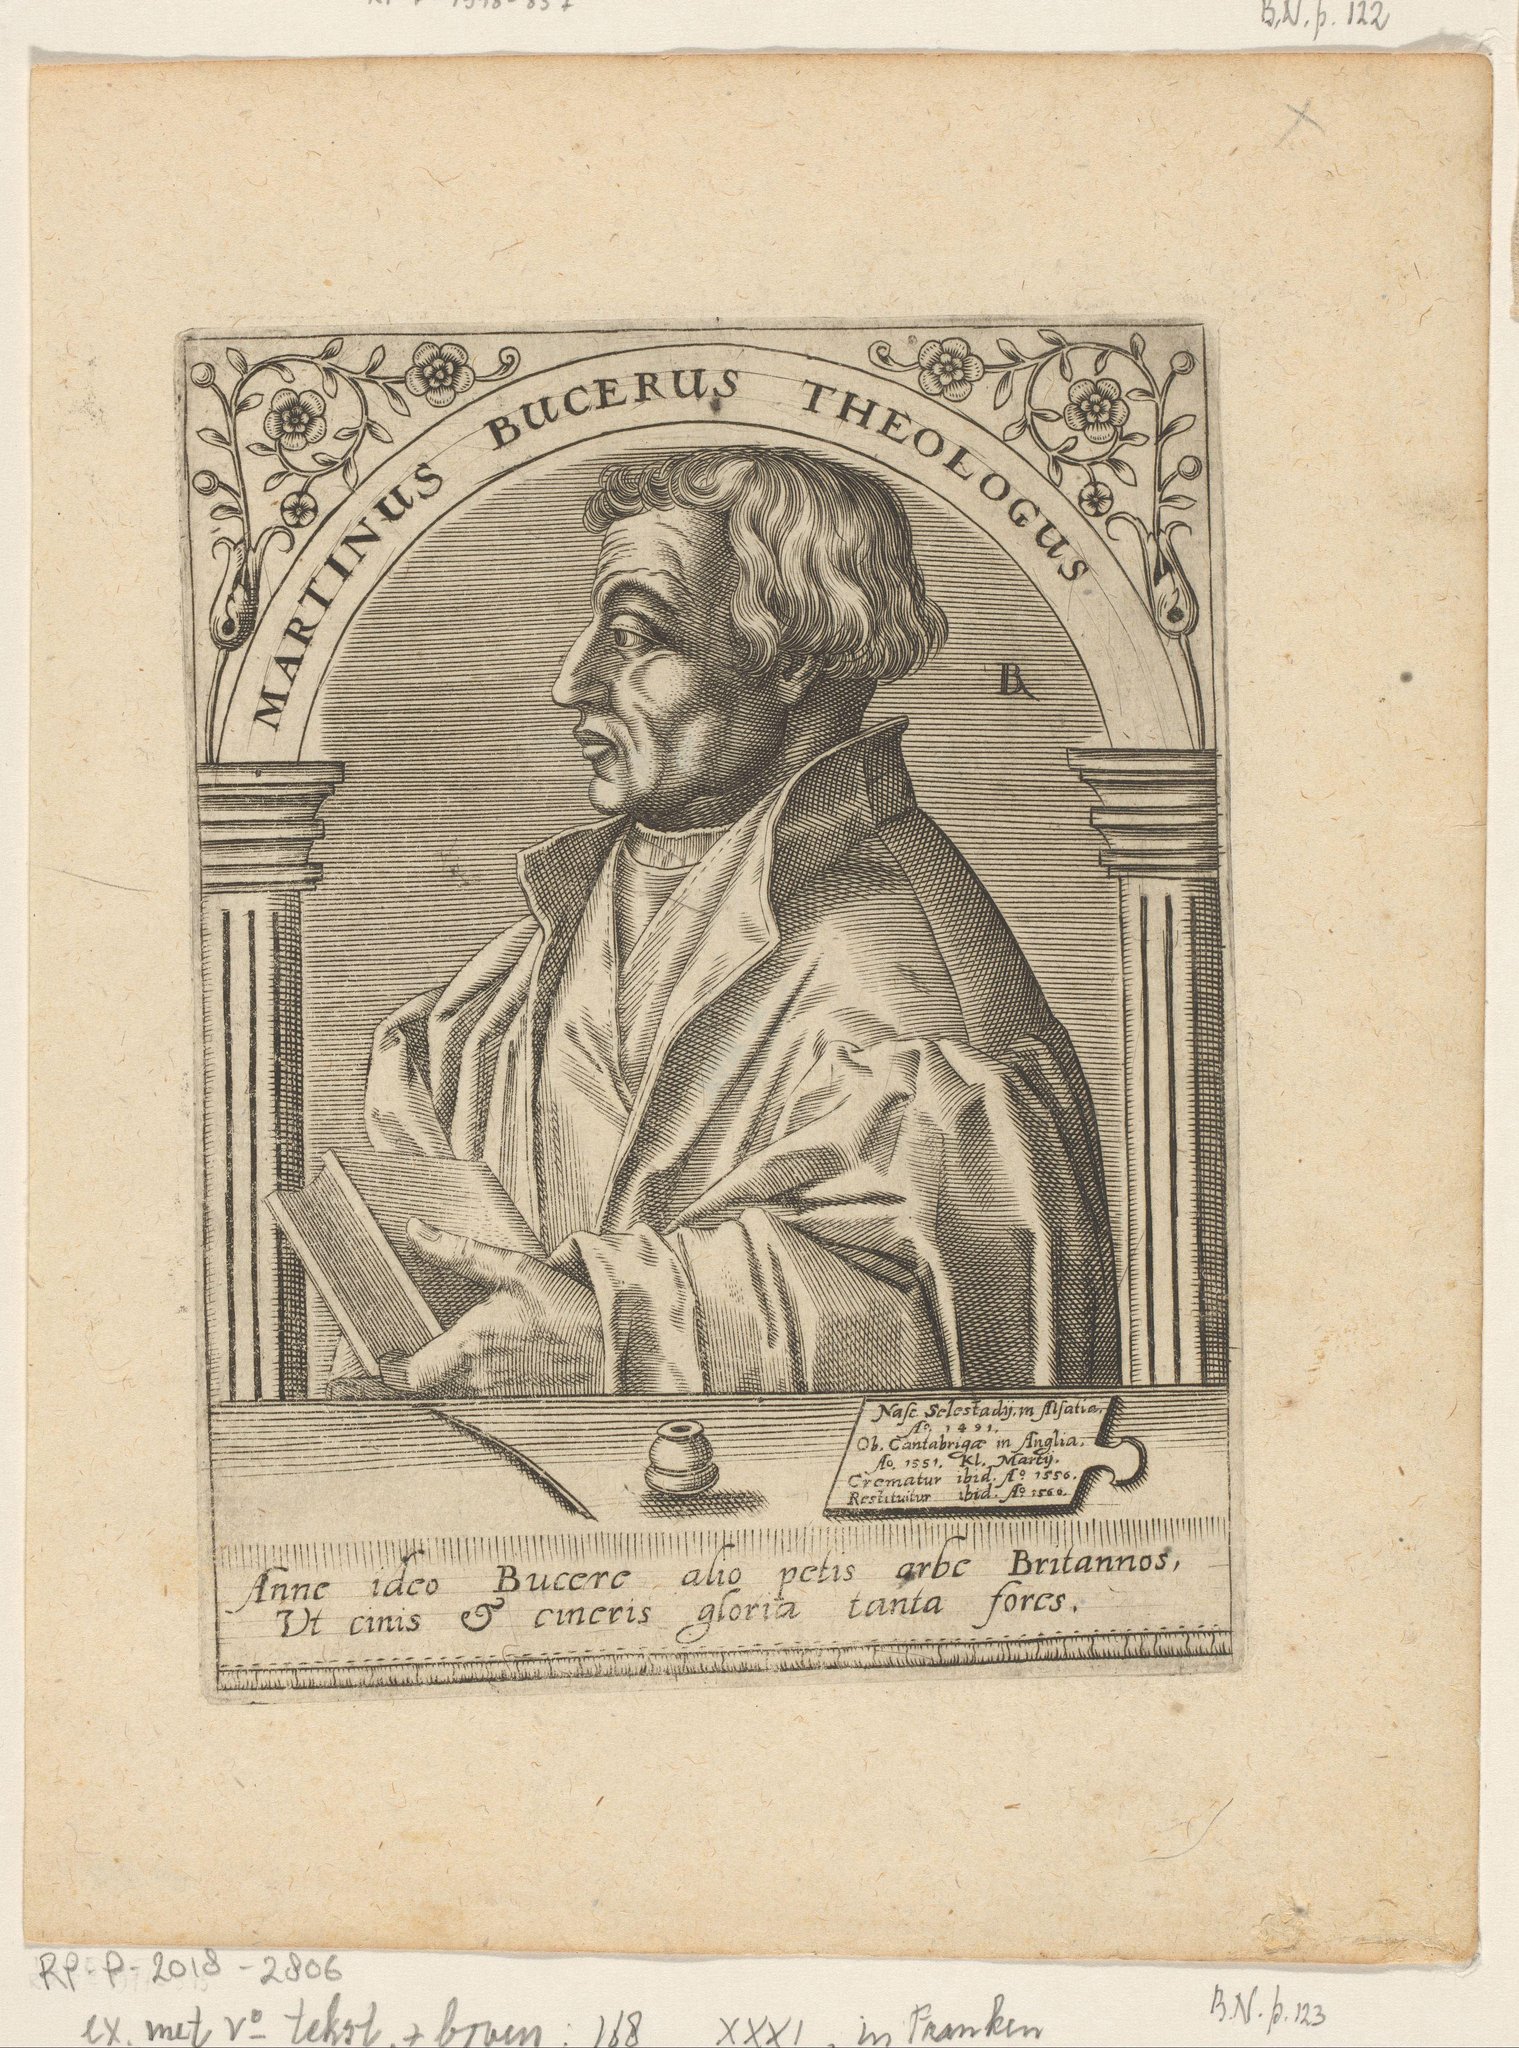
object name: print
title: Martinus Bucerus theologus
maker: robert boissard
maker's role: print maker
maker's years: 1570-1611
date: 1597-1599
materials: paper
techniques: engraving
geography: france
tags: ink-well, historical persons, book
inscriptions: collector's mark: Lugt 2228